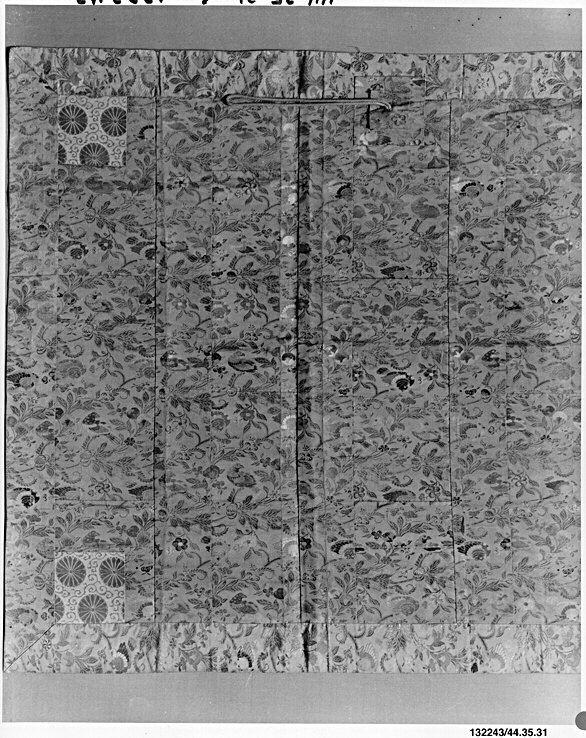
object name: robe, priest's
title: Priest's Robe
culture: japanese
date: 1801-1833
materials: metal thread, silk